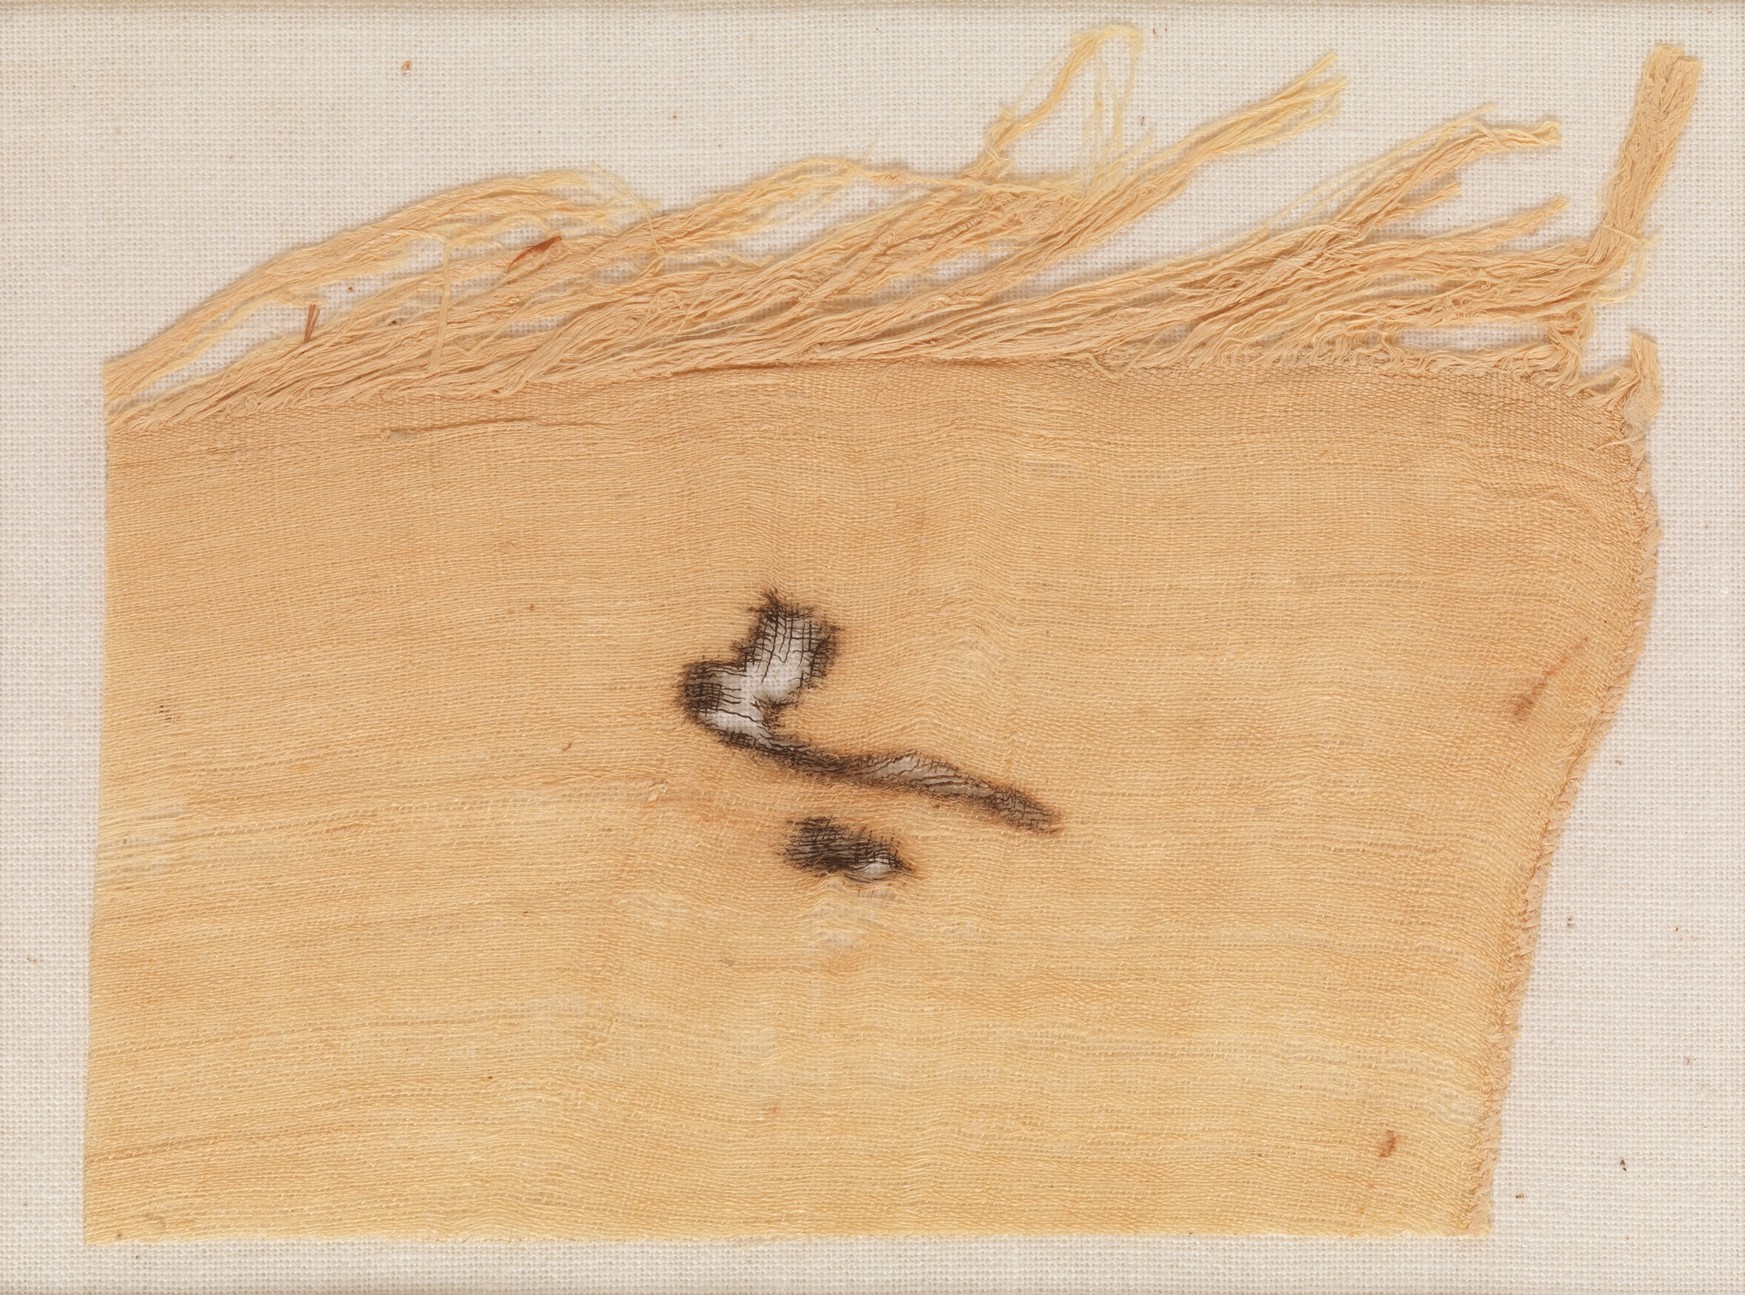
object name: linen mark, wah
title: Linen Mark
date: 1981-1975 BCE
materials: linen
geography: egypt